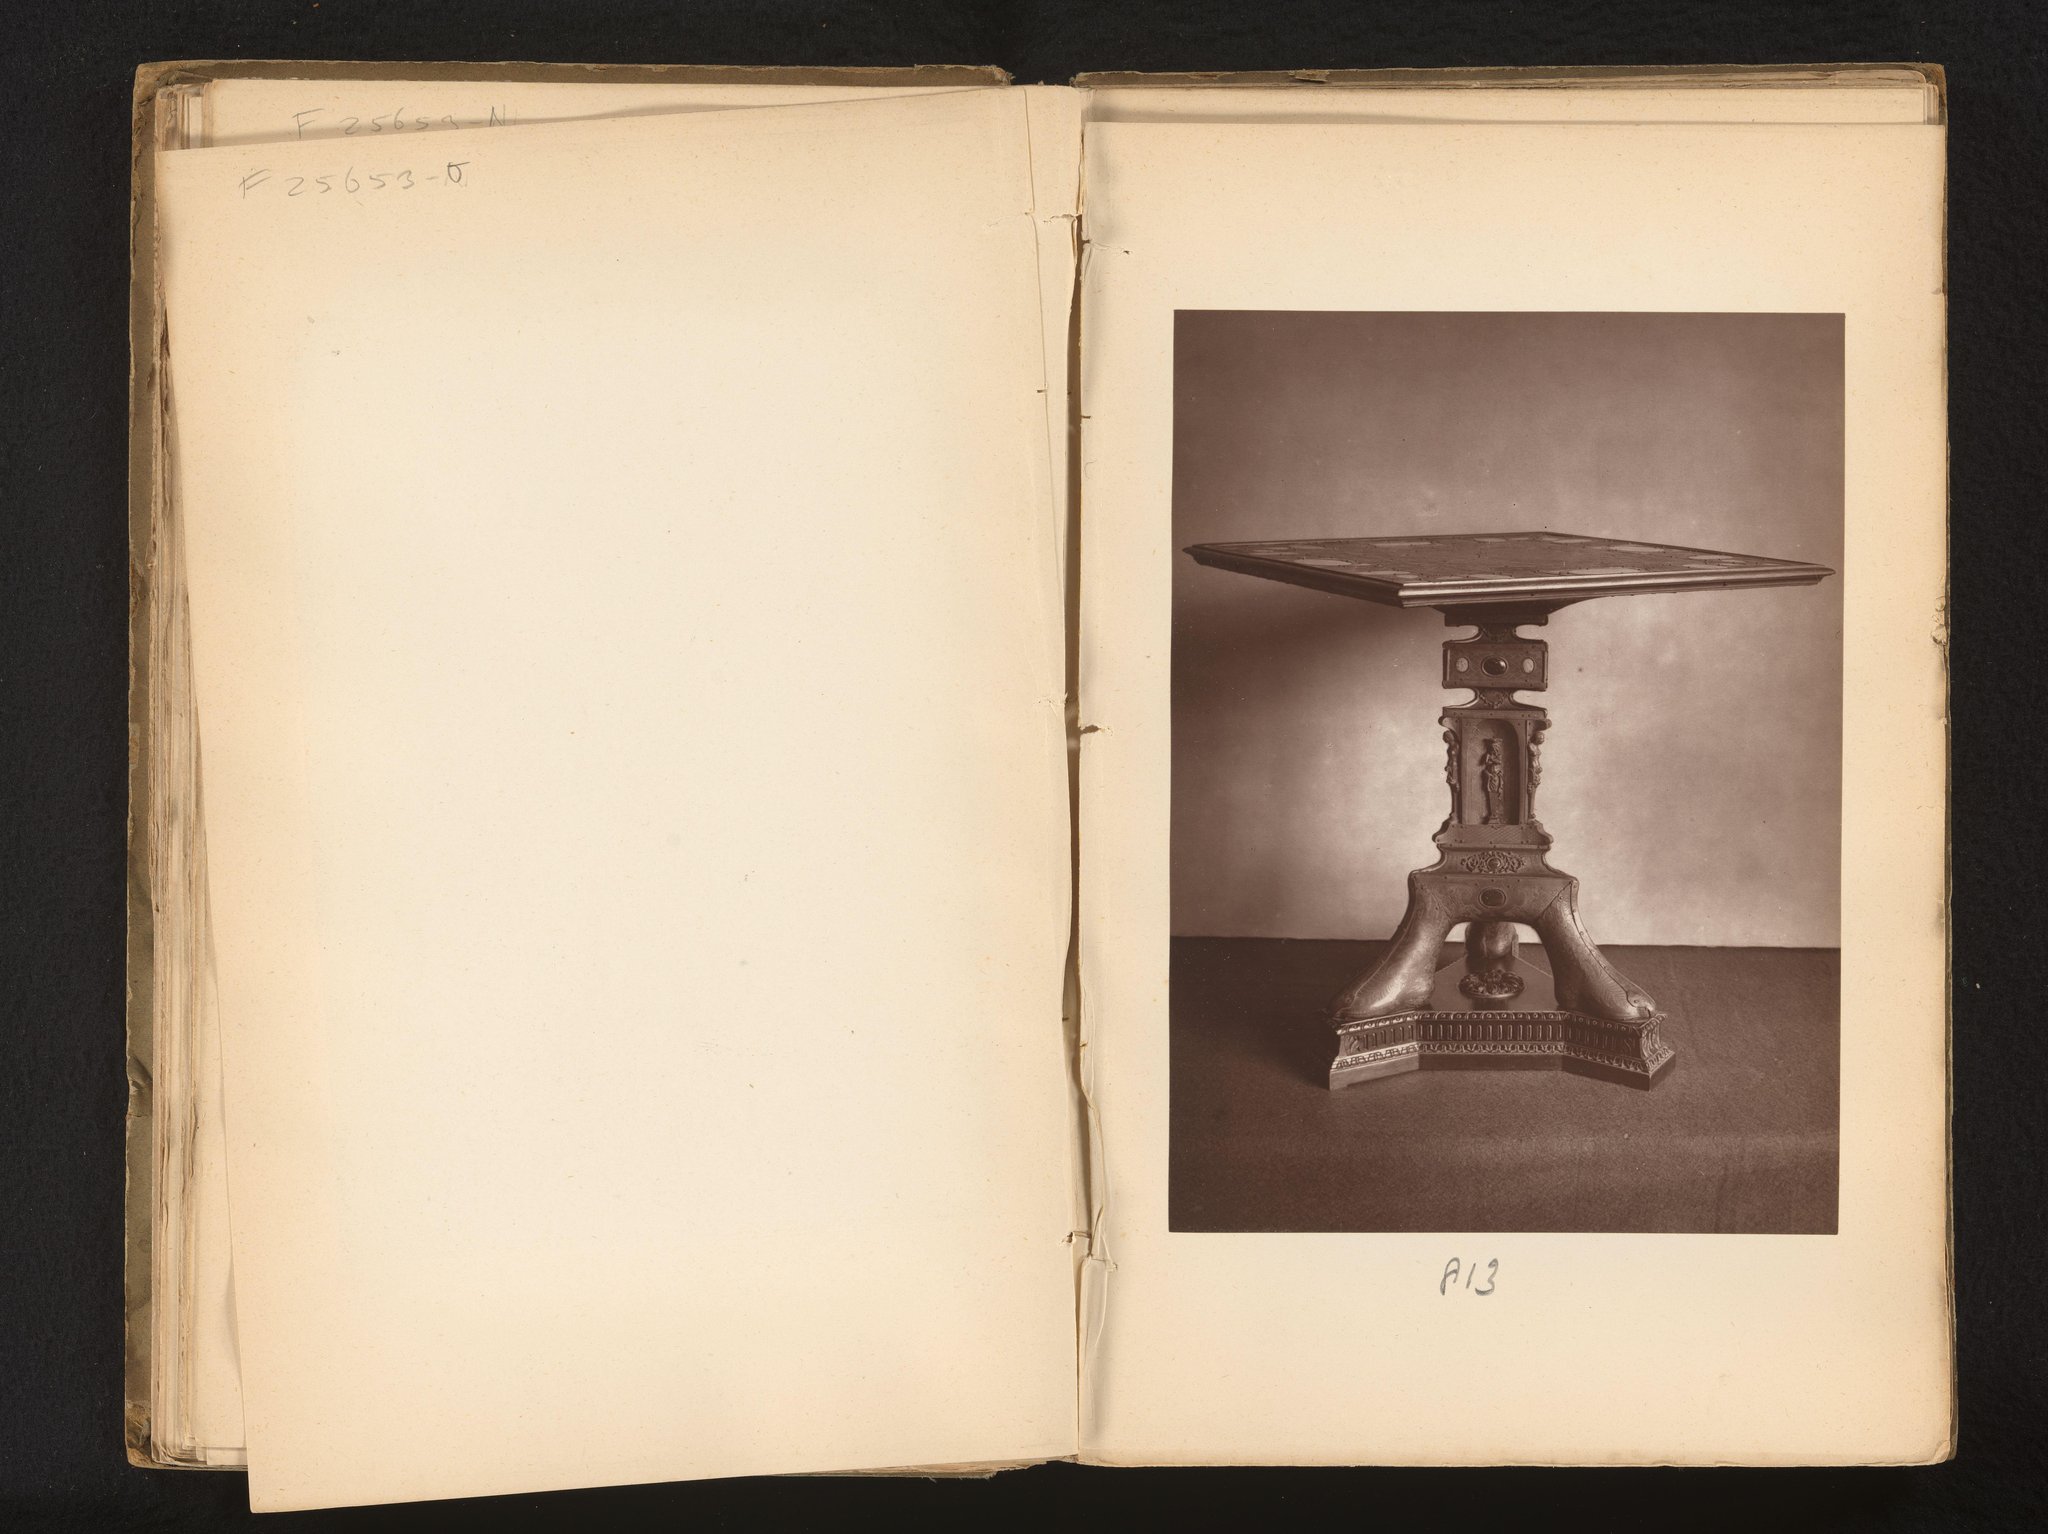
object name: page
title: Tafel voor een schaakbord, uit de collectie van Christopher Beckett Denison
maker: Anonymous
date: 1880-1885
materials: paper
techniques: woodburytype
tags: chess, table (+ wood and other phytogenic material)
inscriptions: number: ‘813’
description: Prent op vijfde ongenummerde pagina na pagina 80.